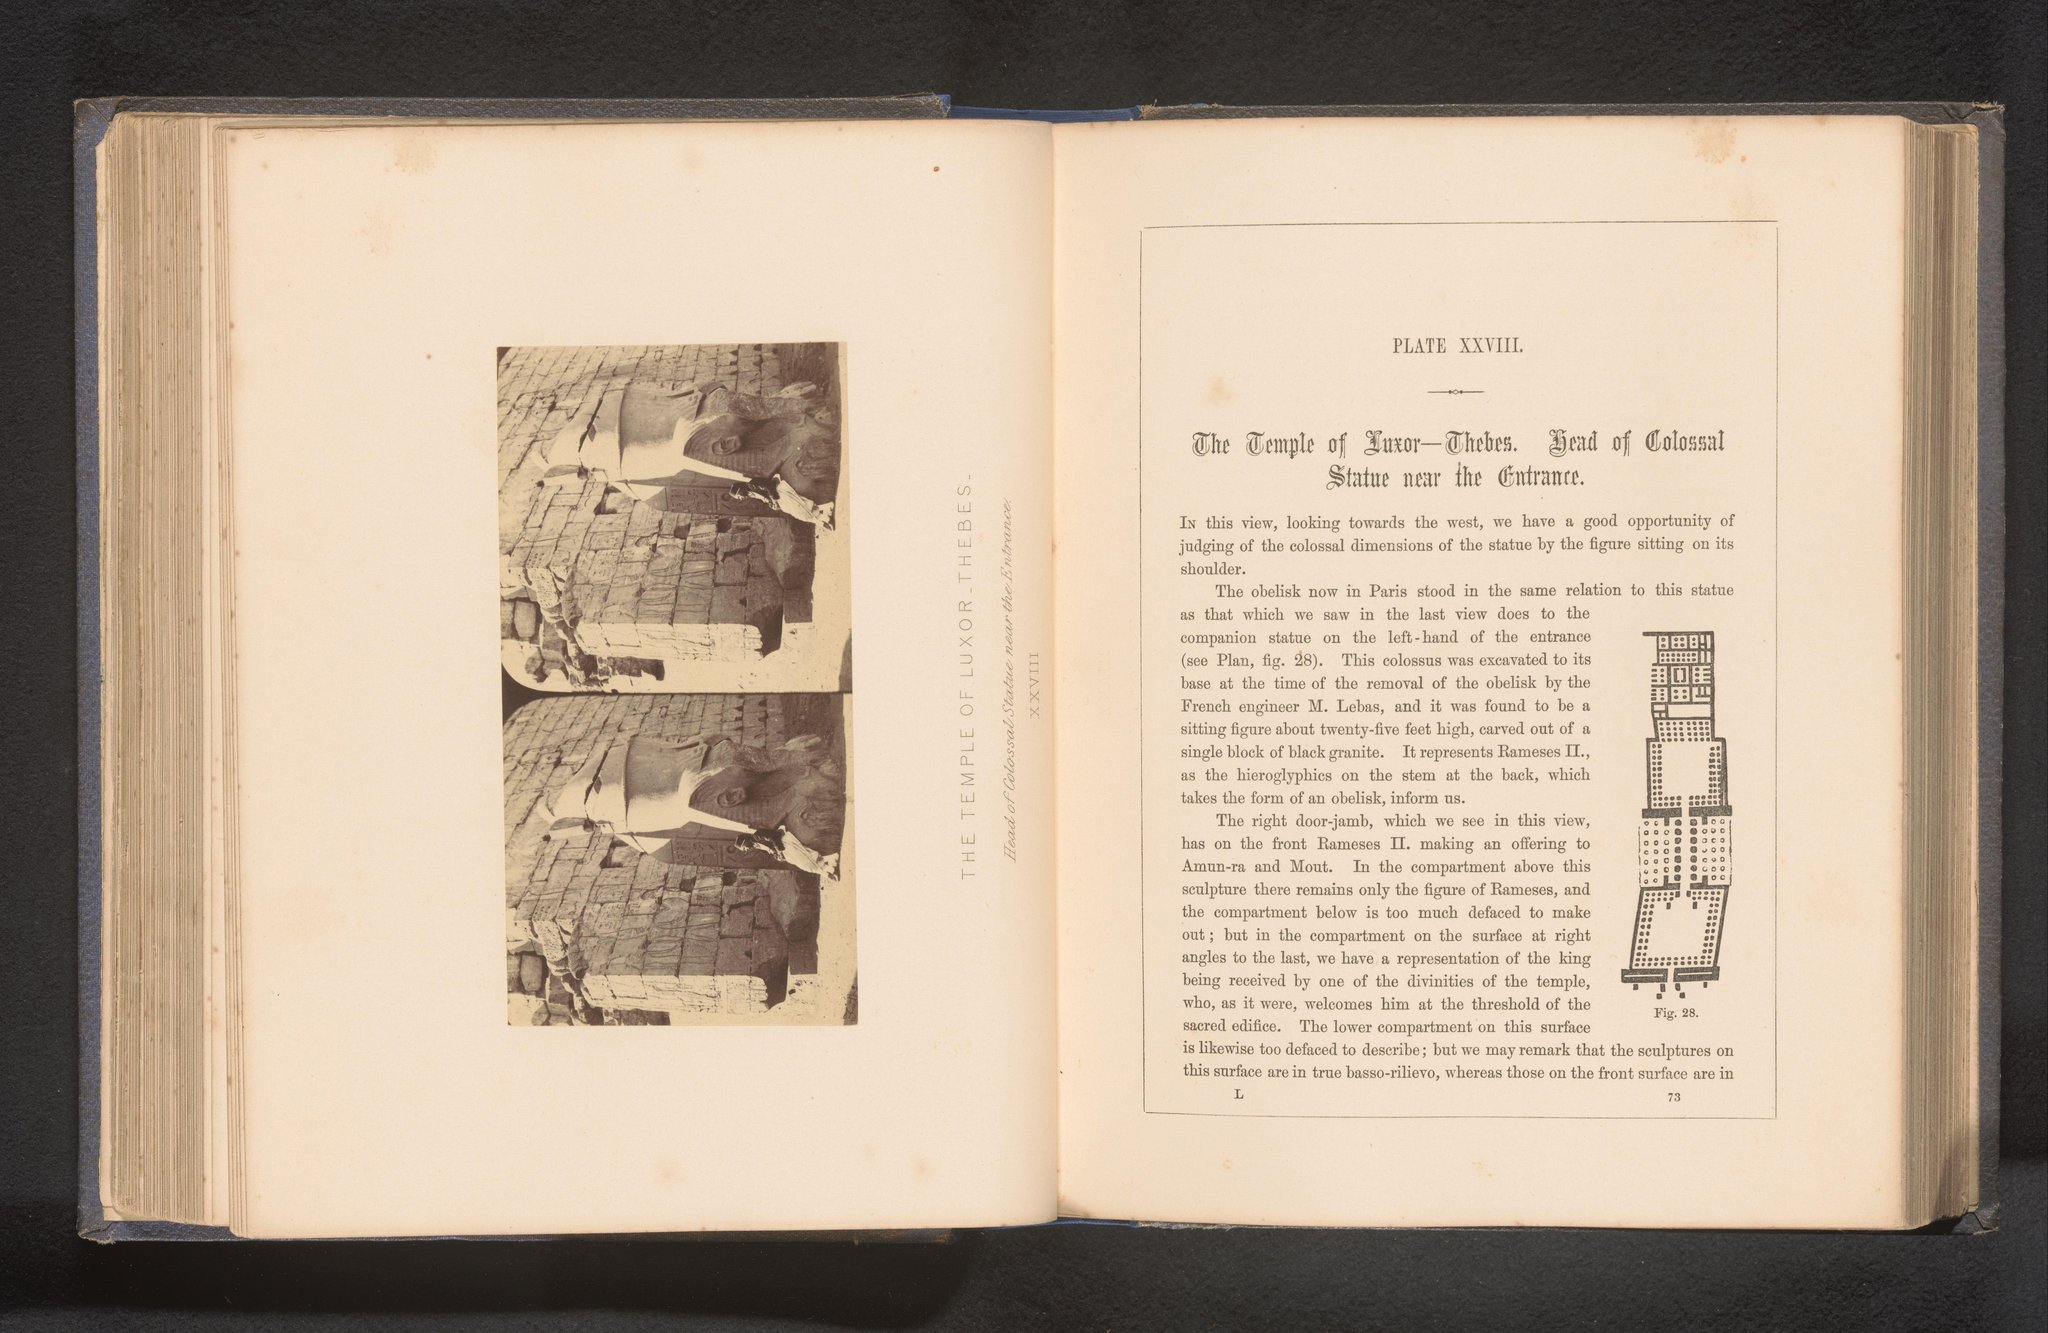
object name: stereograph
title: Onbekende man leunt tegen een fragment van een beeld, de kop van Ramses II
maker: francis frith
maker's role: publisher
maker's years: 1822-1898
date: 1857-1862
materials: photographic support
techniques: albumen print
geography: luxor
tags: temple, shrine ~ egyptian religion, historical persons, monument, statue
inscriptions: inscription: ‘Head of colossal statue near the entrance’, name: ‘Frith’, number: ‘XXVIII’